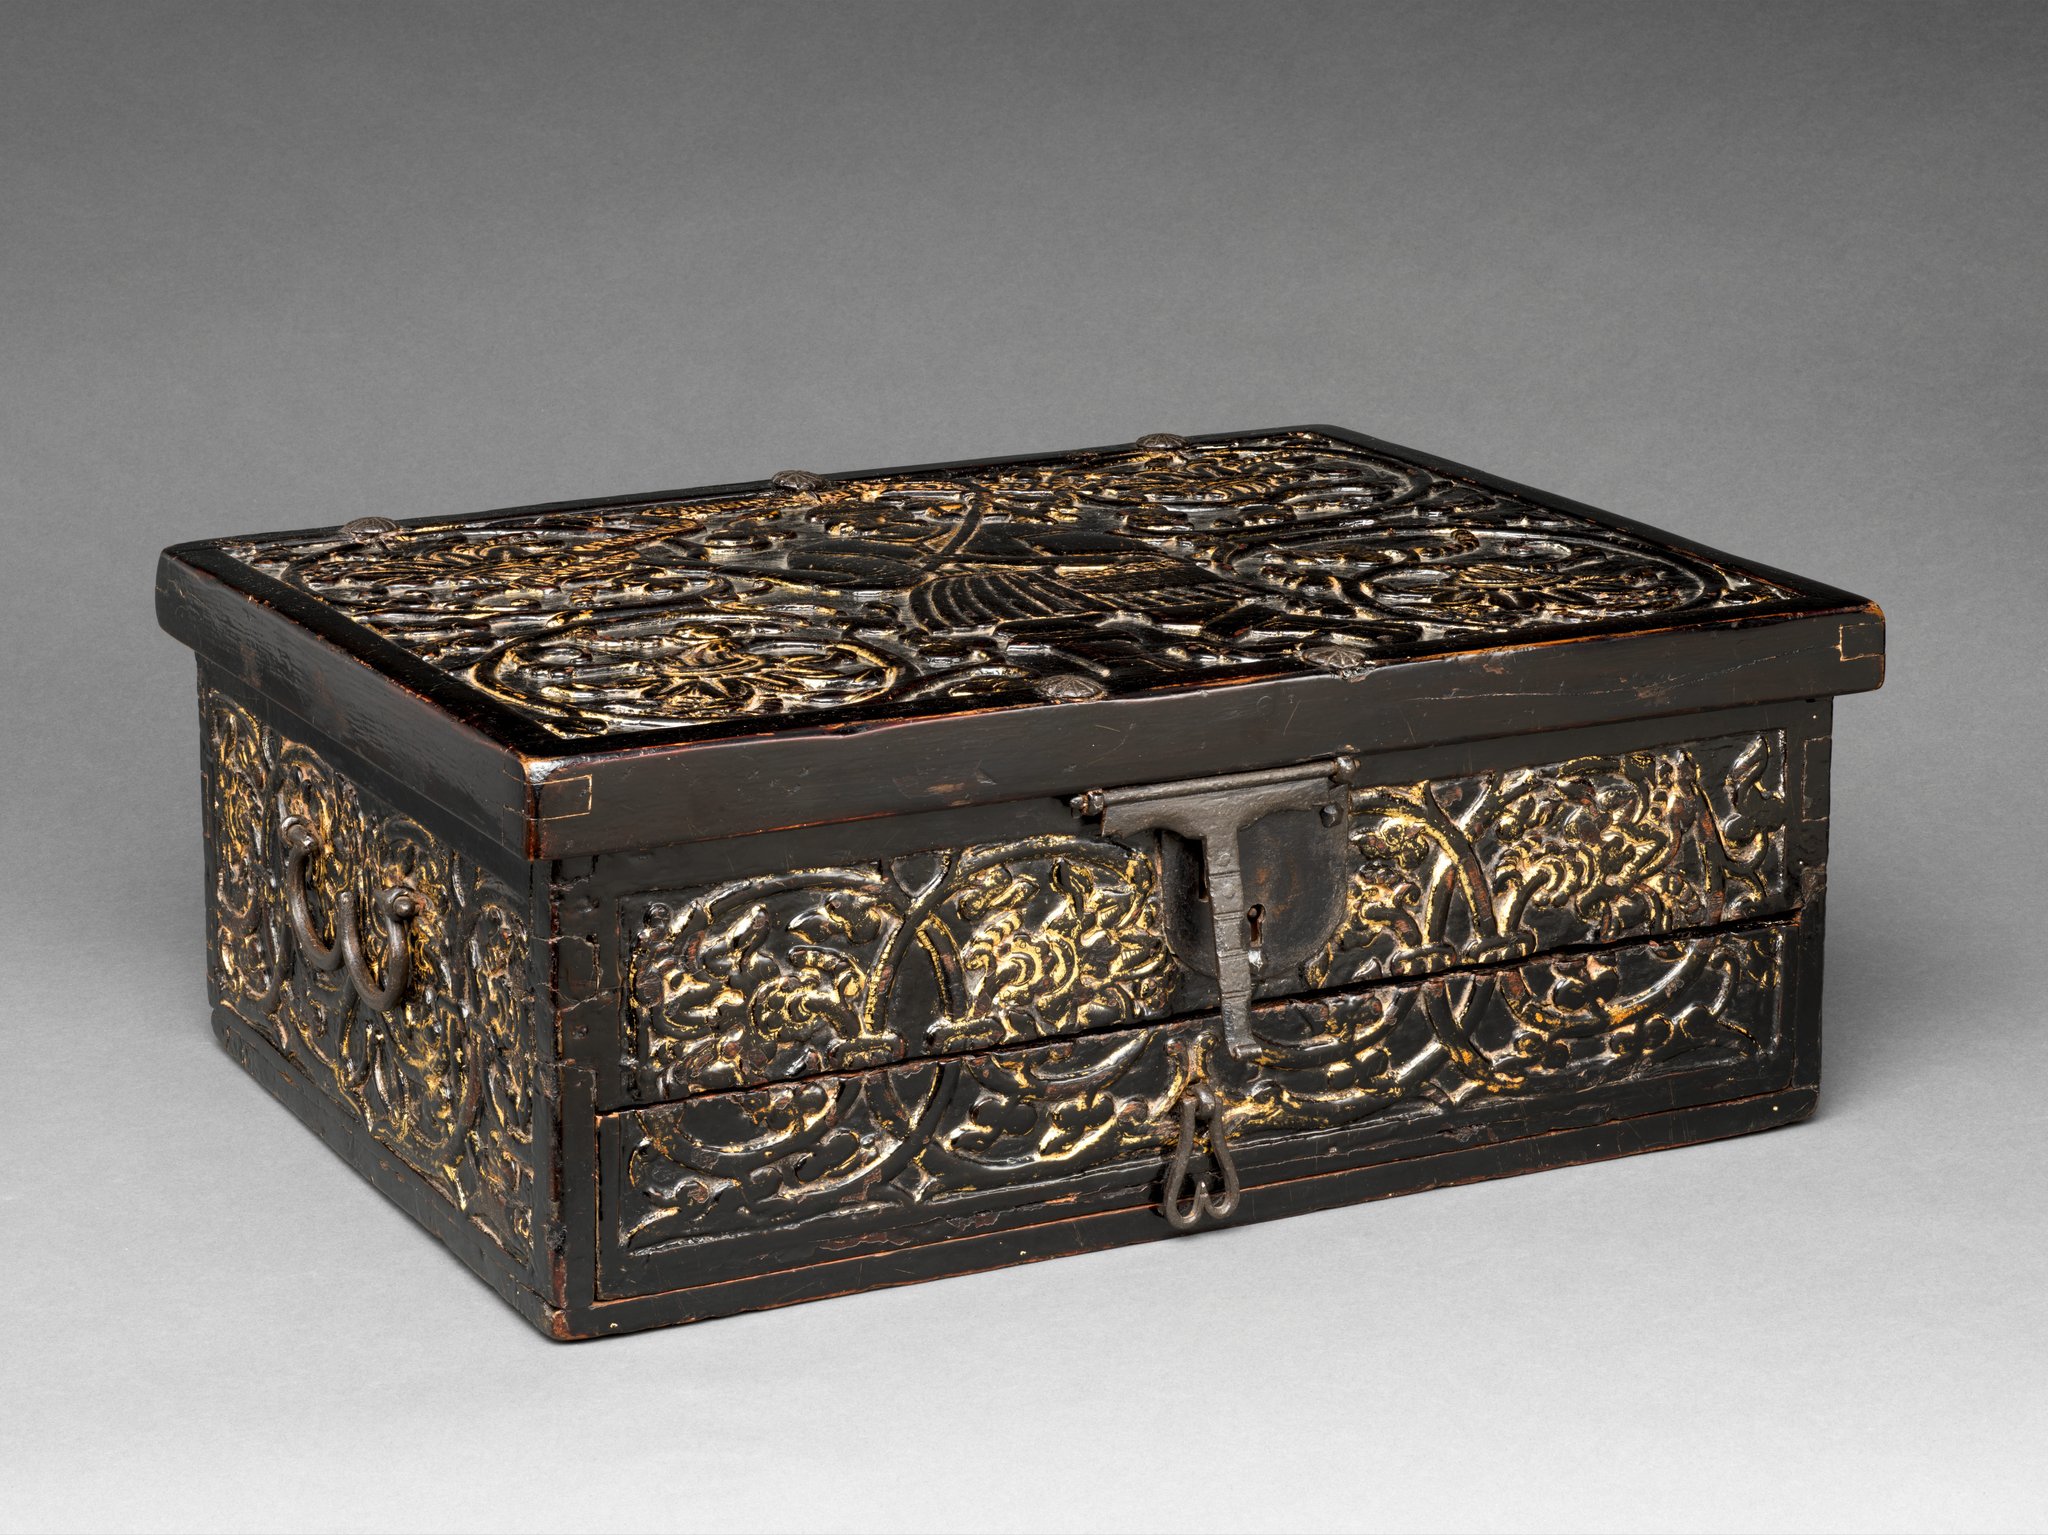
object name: writing box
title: Writing box with Camões inscription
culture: burmese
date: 1567-1600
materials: gold, iron, lacquer, wood